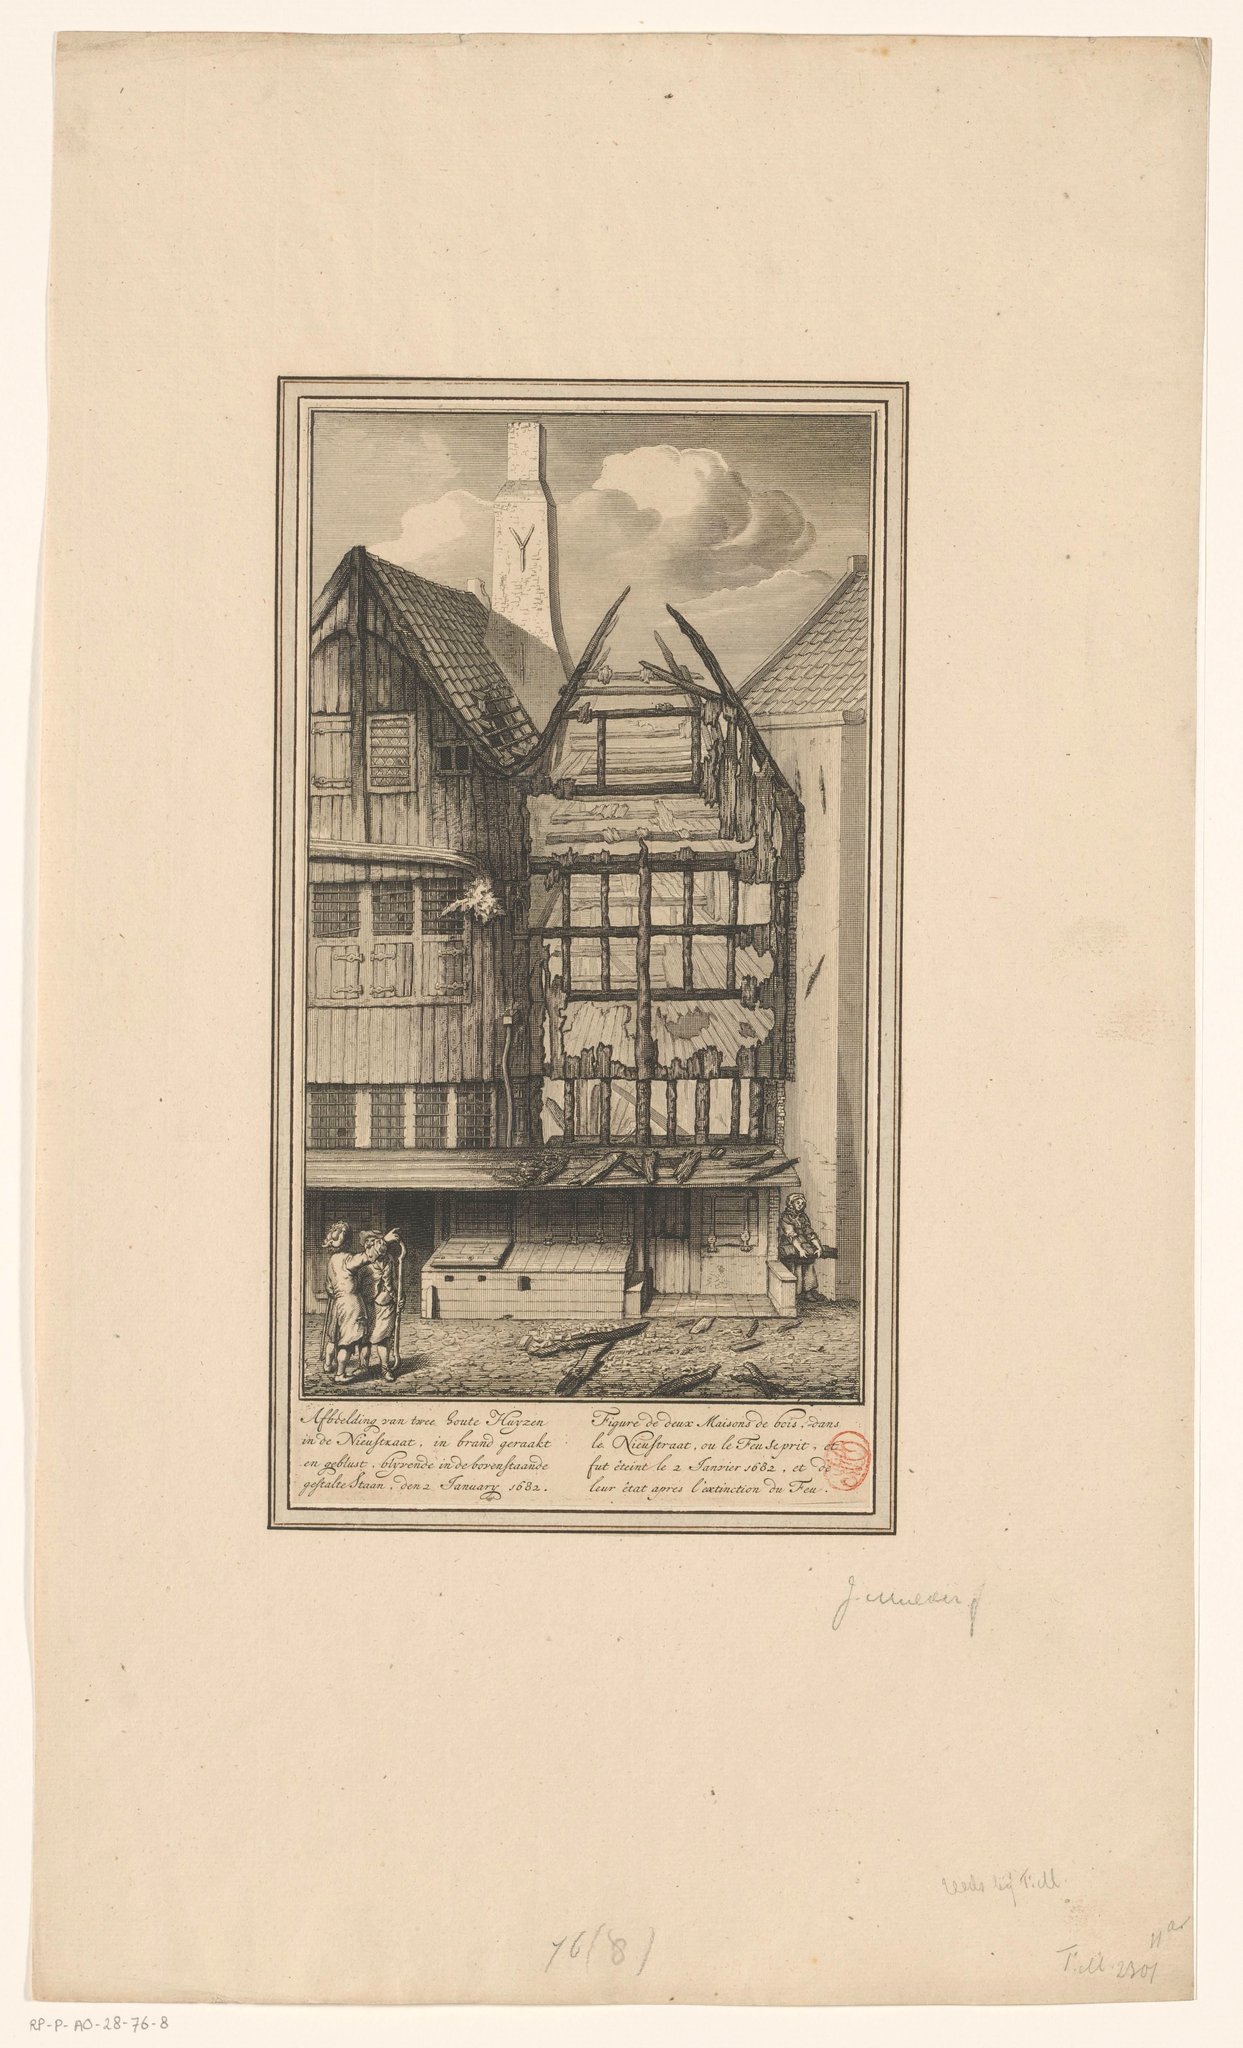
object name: book illustration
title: Twee uitgebrande huizen in de Oude Nieuwstraat, 1682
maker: jan van der heyden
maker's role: draughtsman, painter, print maker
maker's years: 1637-1712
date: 1690-1735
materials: paper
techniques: engraving, etching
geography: amsterdam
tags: painter, print maker, draughtsman, jan van der heyden, urban housing, ruin of a building ~ architecture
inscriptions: collector's mark: Lugt 2228, collector's mark: Lugt 195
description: Prent ook gebruikt in: Heyden, Jan van der. Beschryving der nieuwlyks uitgevonden en geoctrojeerde slang-brand-spuiten en haare wyze van brand-blussen, tegenwoordig binnen Amsterdam in gebruik zijnde (…). 1e druk. Amsterdam: Jan Rieuwertsz. (II), 1690. En in: Heyden, Jan van der. Beschryving der nieuwlyks uitgevonden en geoctrojeerde slang-brand-spuiten en haare wyze van brand-blussen, tegenwoordig binnen Amsterdam in gebruik zijnde (…). 2e druk. Amsterdam: erfgenamen Jan van der Heyden, 1735. Voor ontwerptekeningen zie RP-T-00-732 en RP-T-00-733.